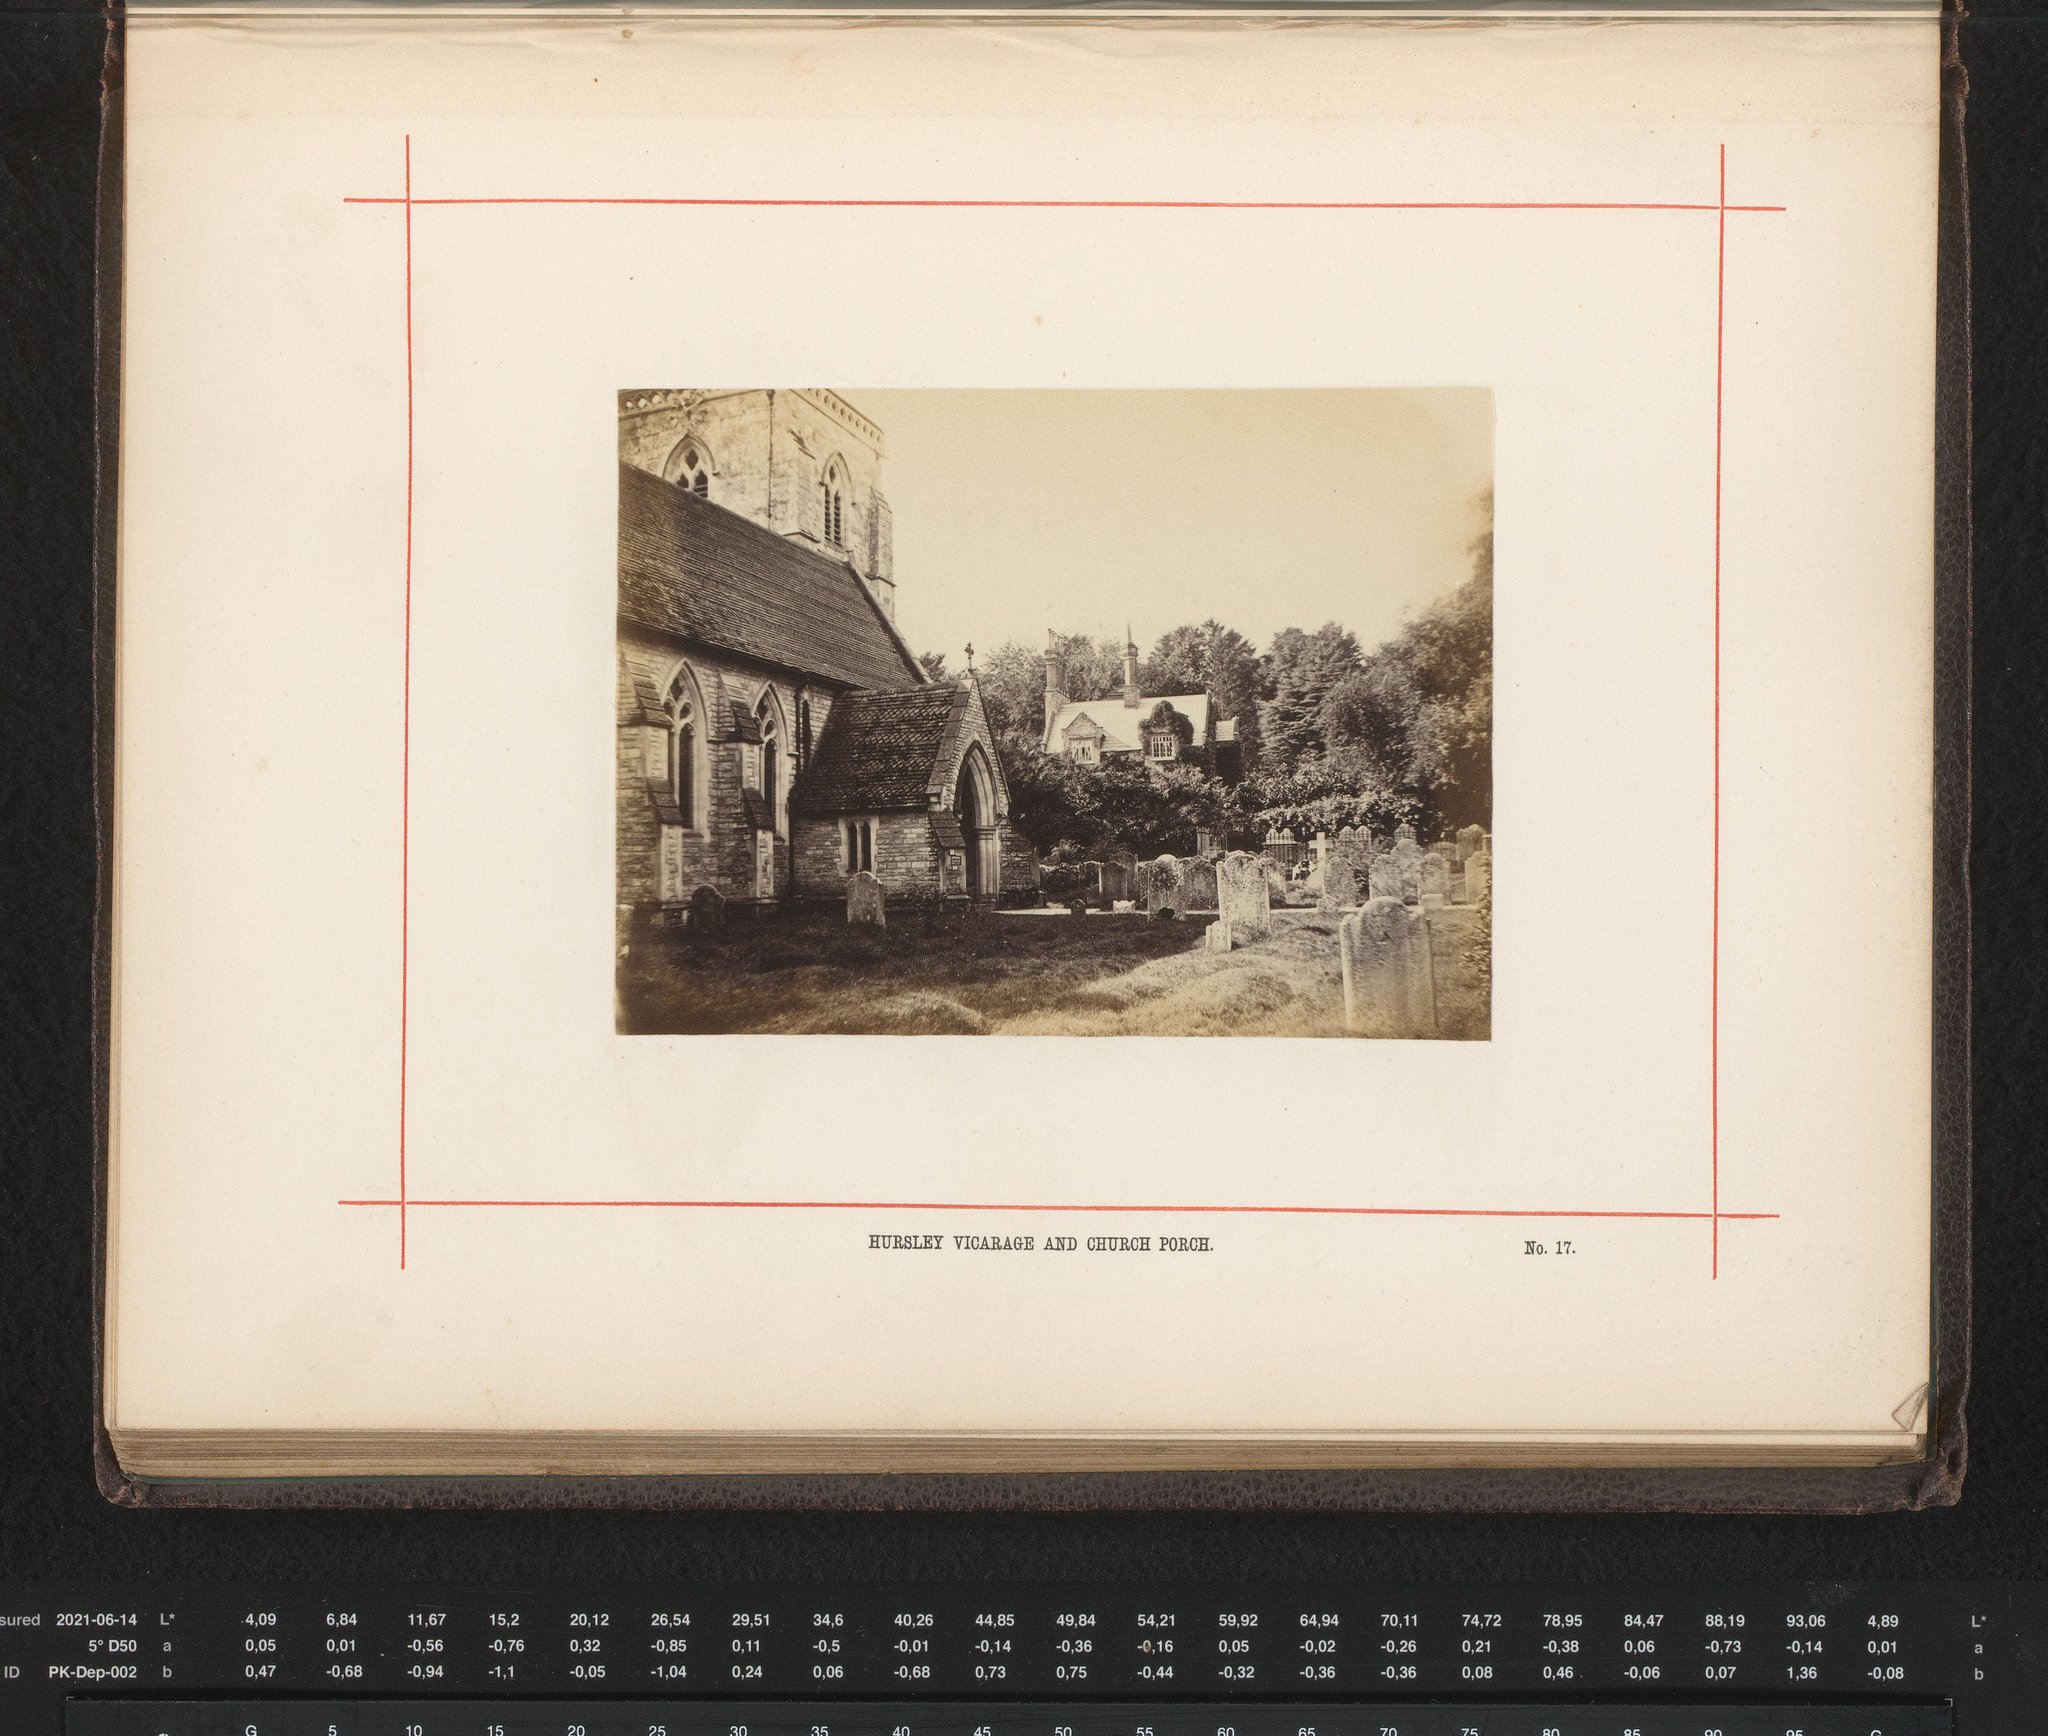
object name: page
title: Hursley Vicarage and Church Porch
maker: william savage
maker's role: fotograaf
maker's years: 1817-1887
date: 1861-1866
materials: paper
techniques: albumen print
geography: hursley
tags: churchyard, cemetery